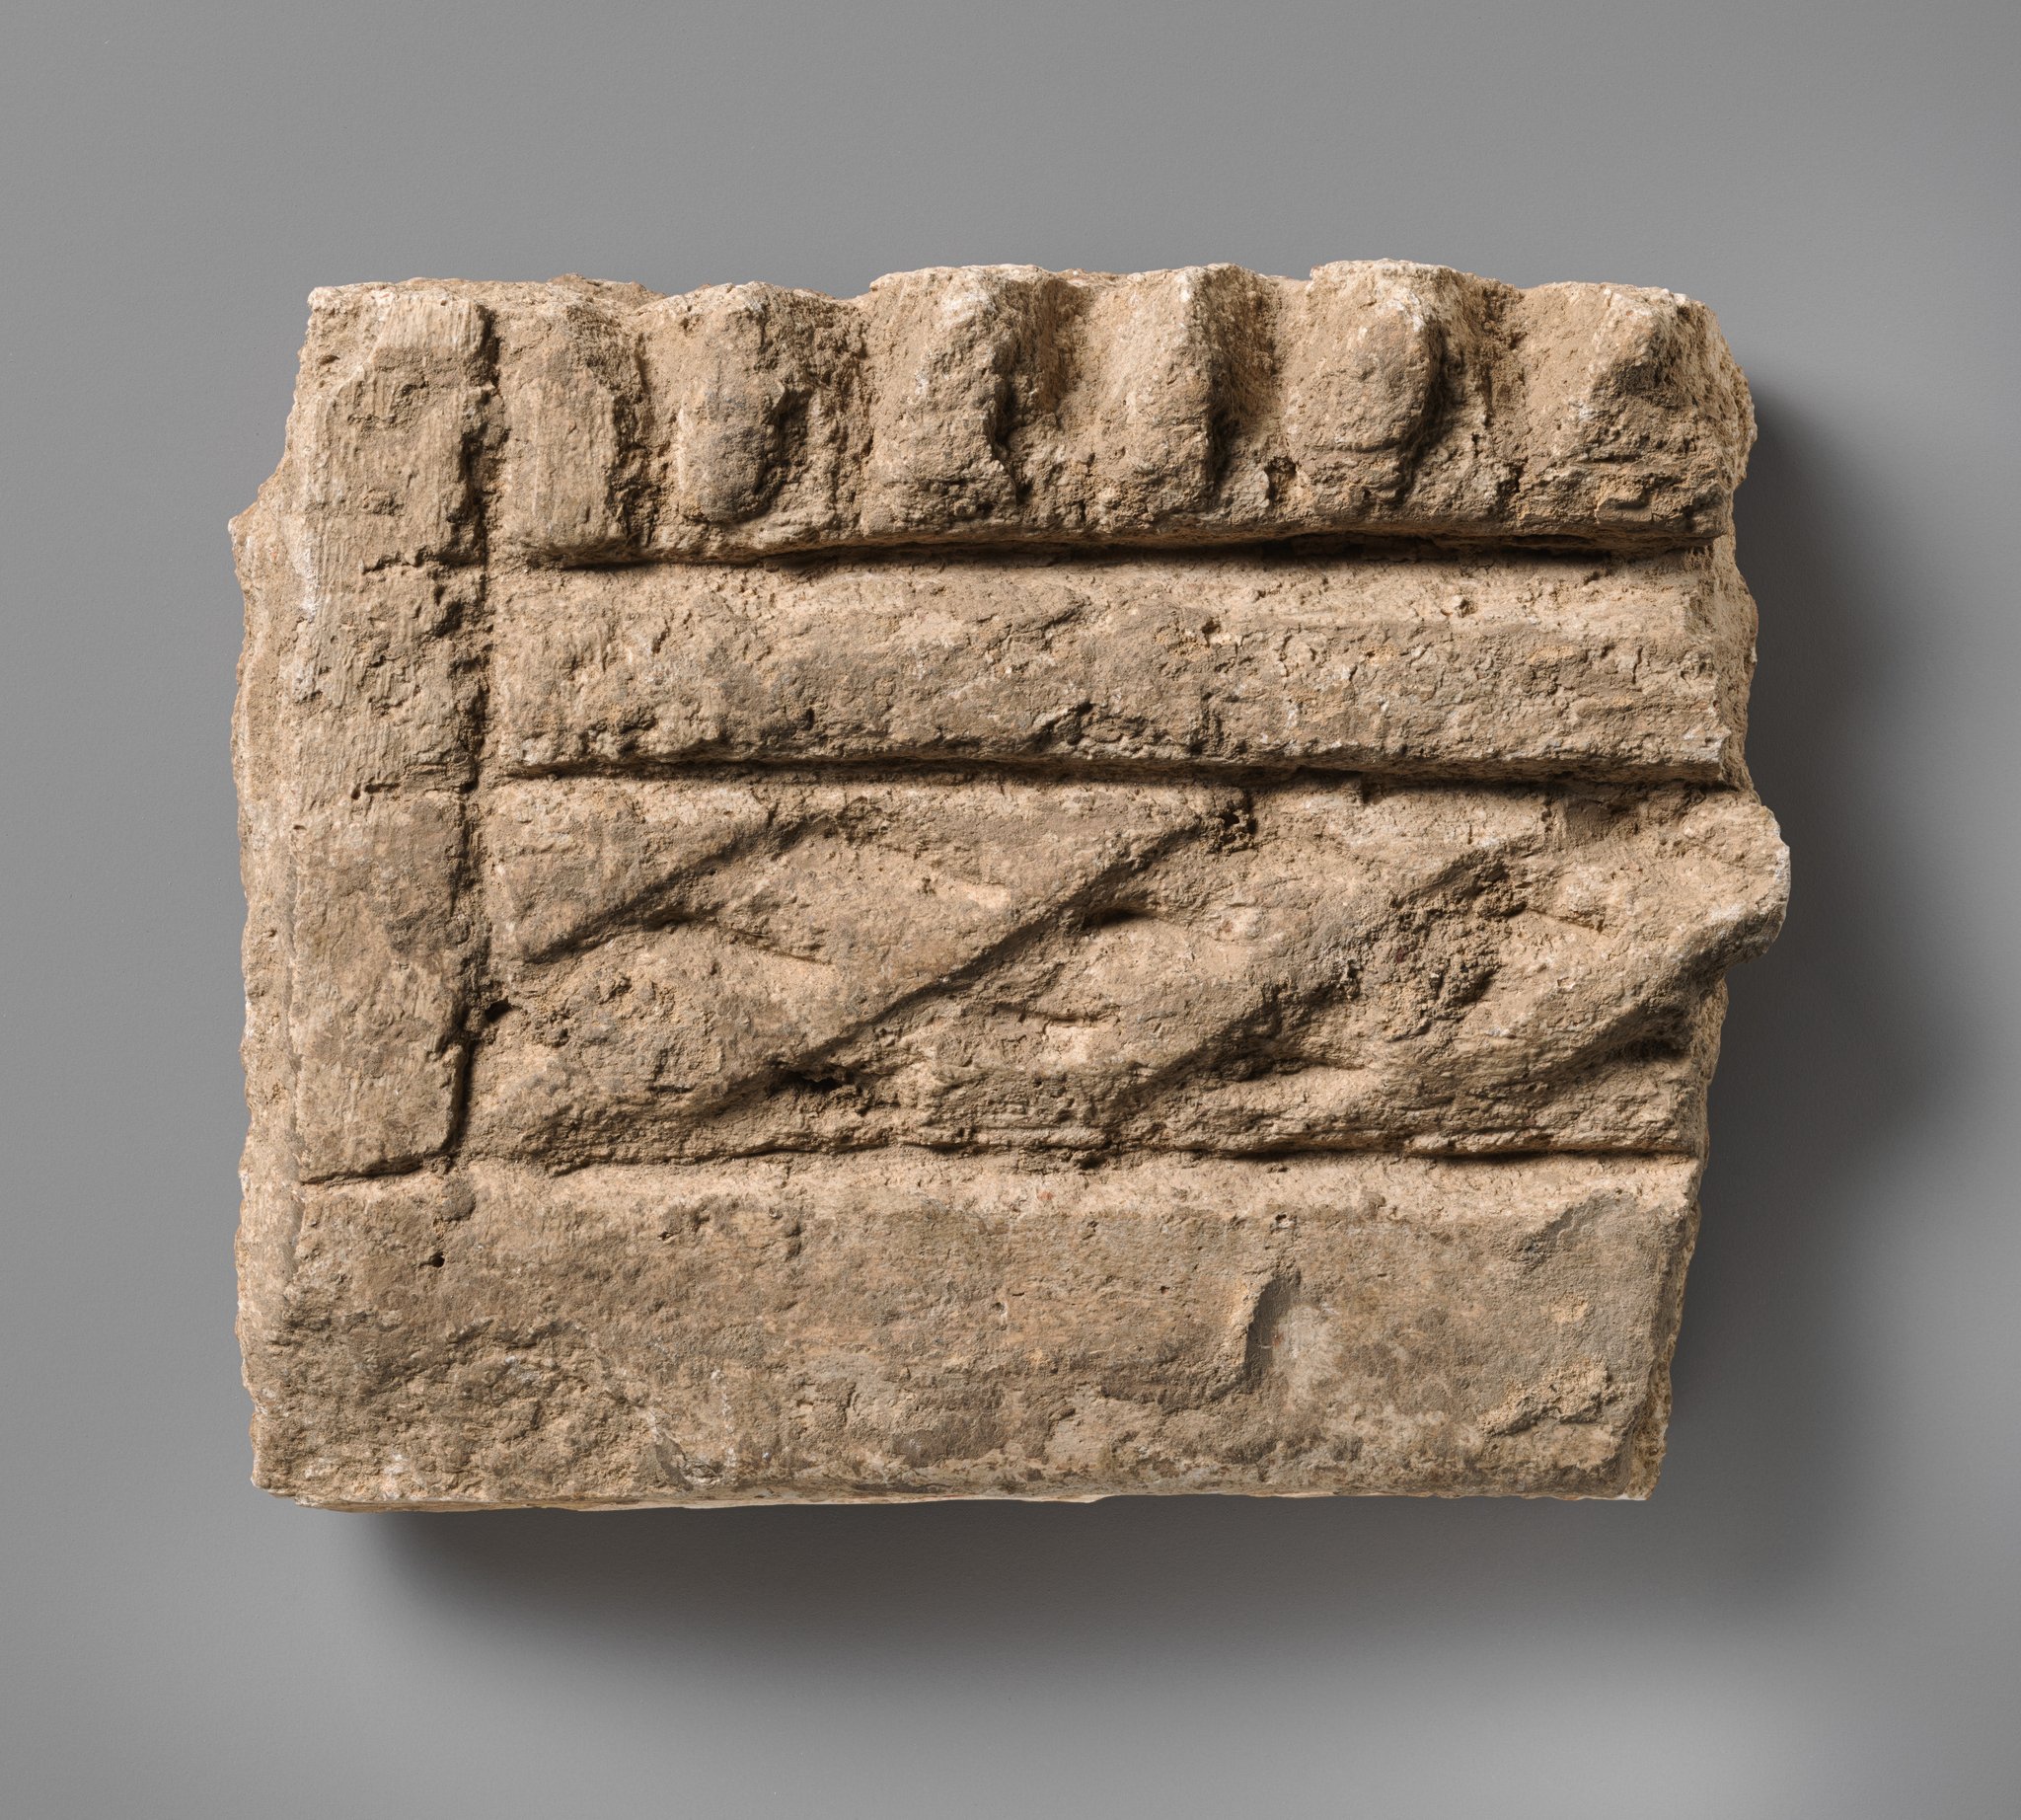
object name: relief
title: Relief fragment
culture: sasanian or islamic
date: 501-800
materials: plaster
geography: mesopotamia